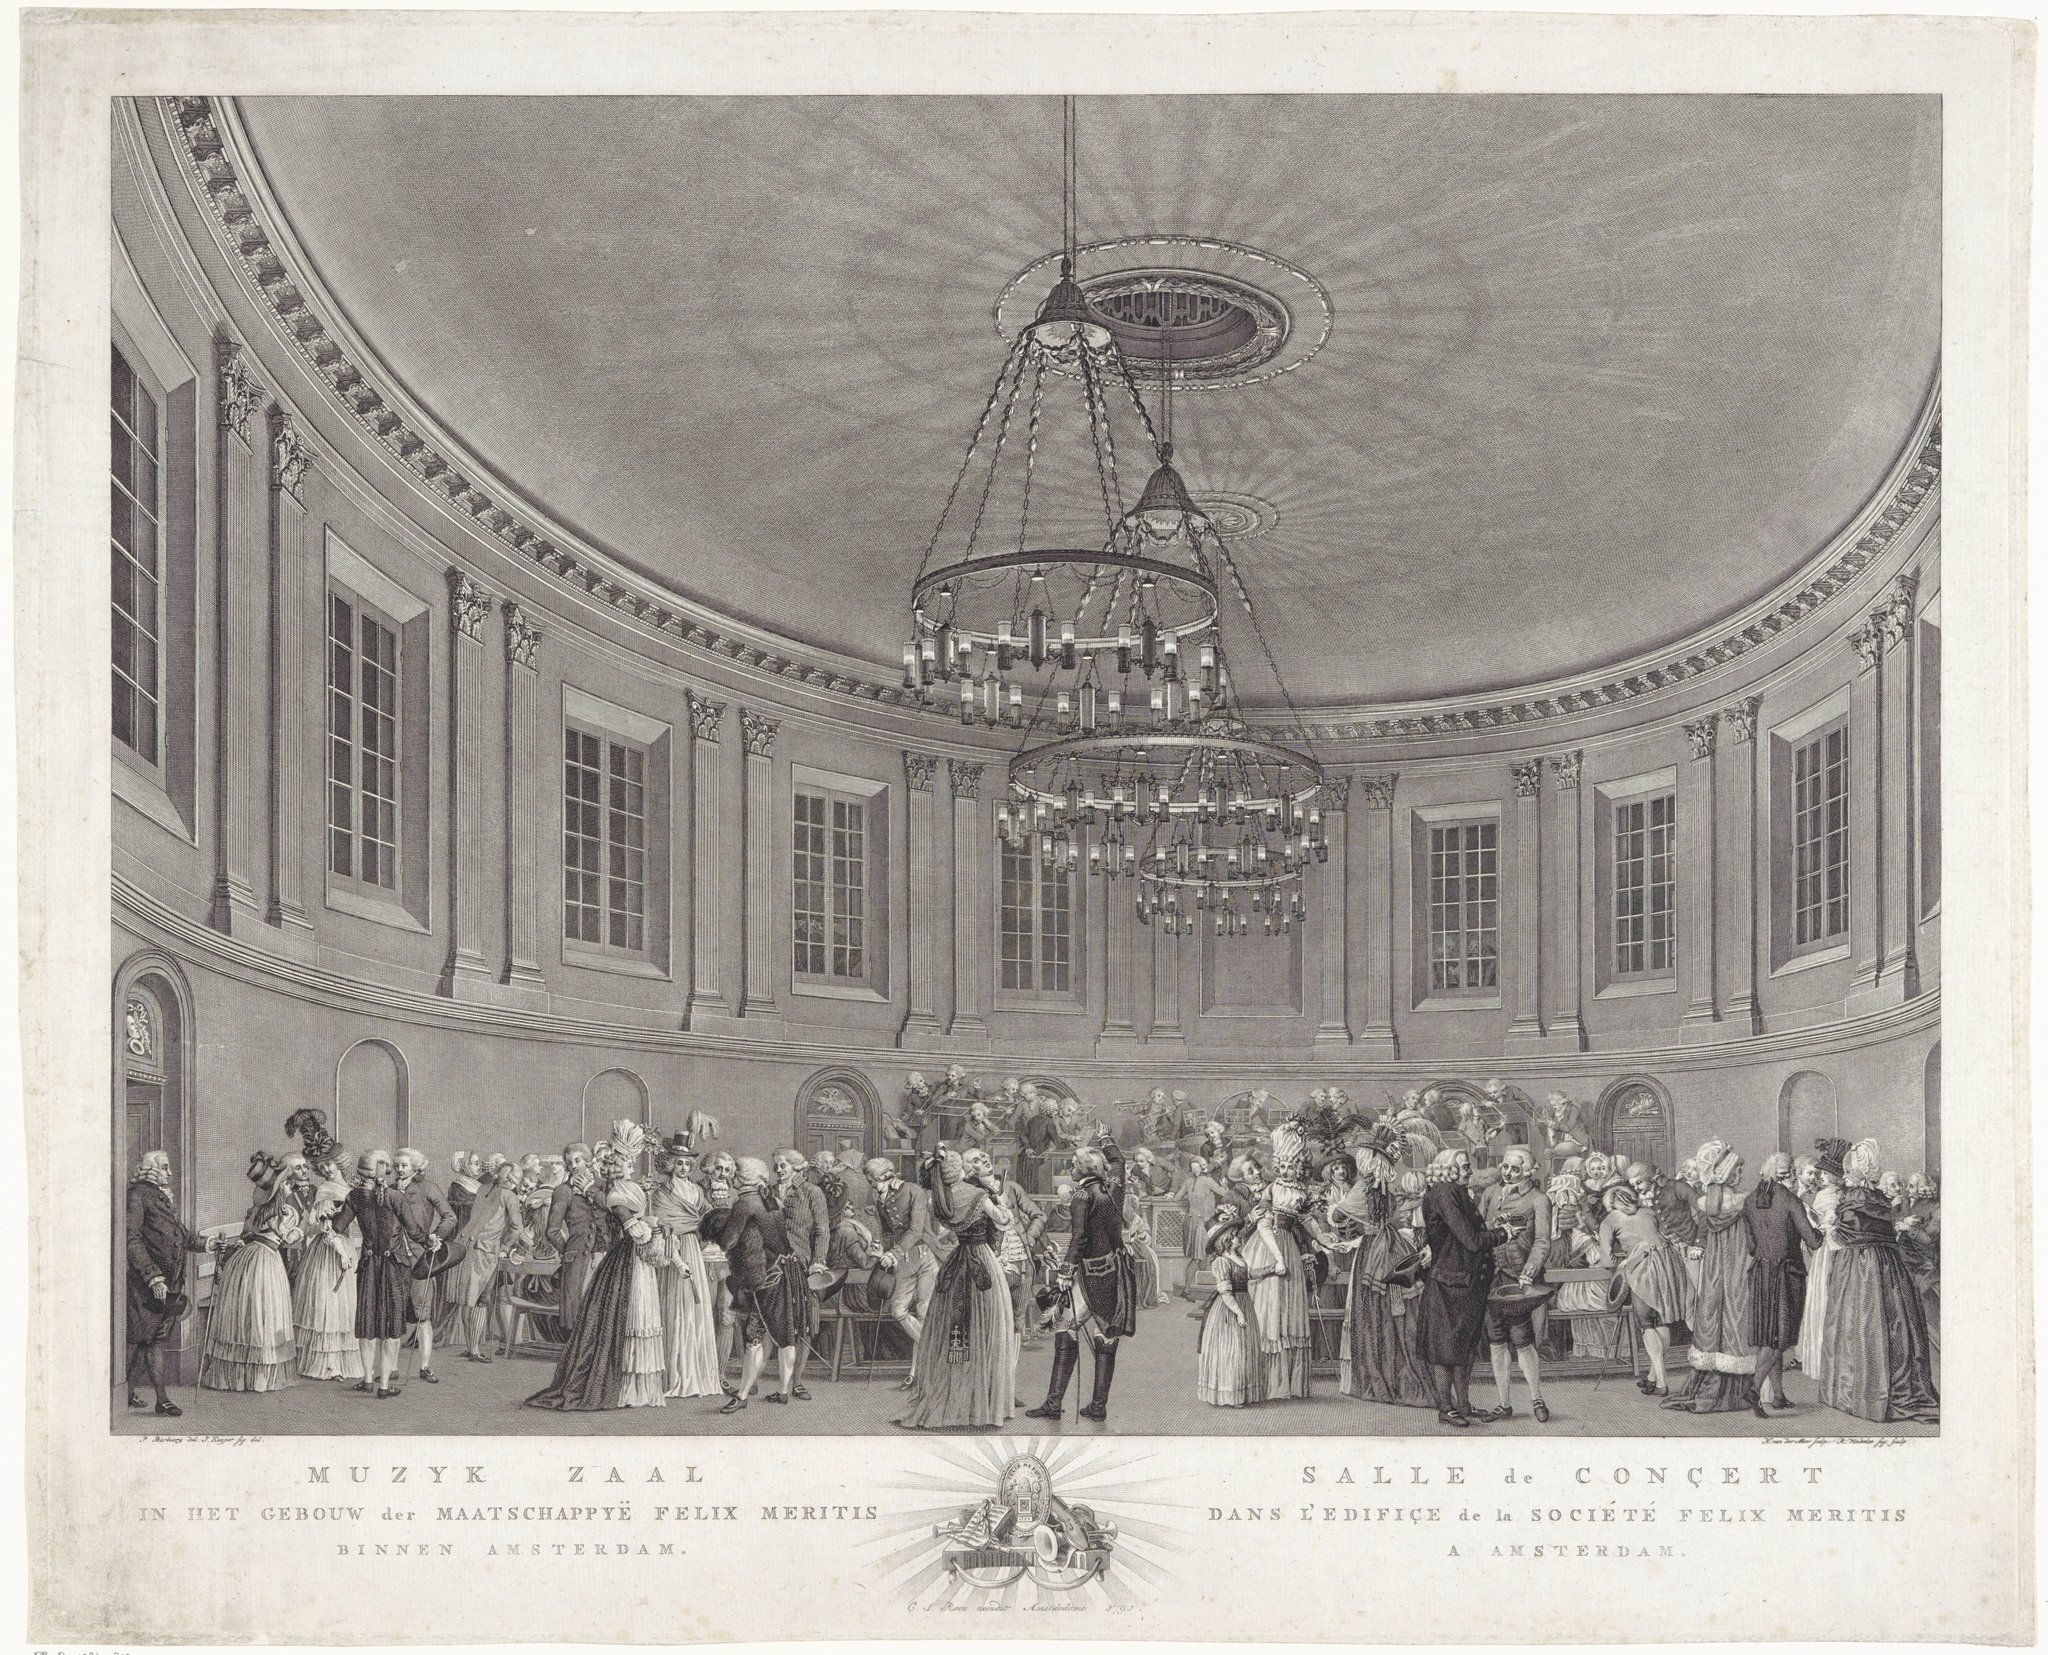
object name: print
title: Vier zalen in Felix Meritis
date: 1791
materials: paper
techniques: engraving, etching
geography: amsterdam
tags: concert hall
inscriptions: collector's mark: Lugt 2233, name: ‘C.J. Roos’, collector's mark: Lugt 2228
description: Bezoekers in de Concertzaal in het gebouw van de maatschappij Felix Meritis te Amsterdam, ingewijd in 1789. Groepjes mensen zijn met elkaar in gesprek, terwijl op het podium het orkest zich voorbereidt.